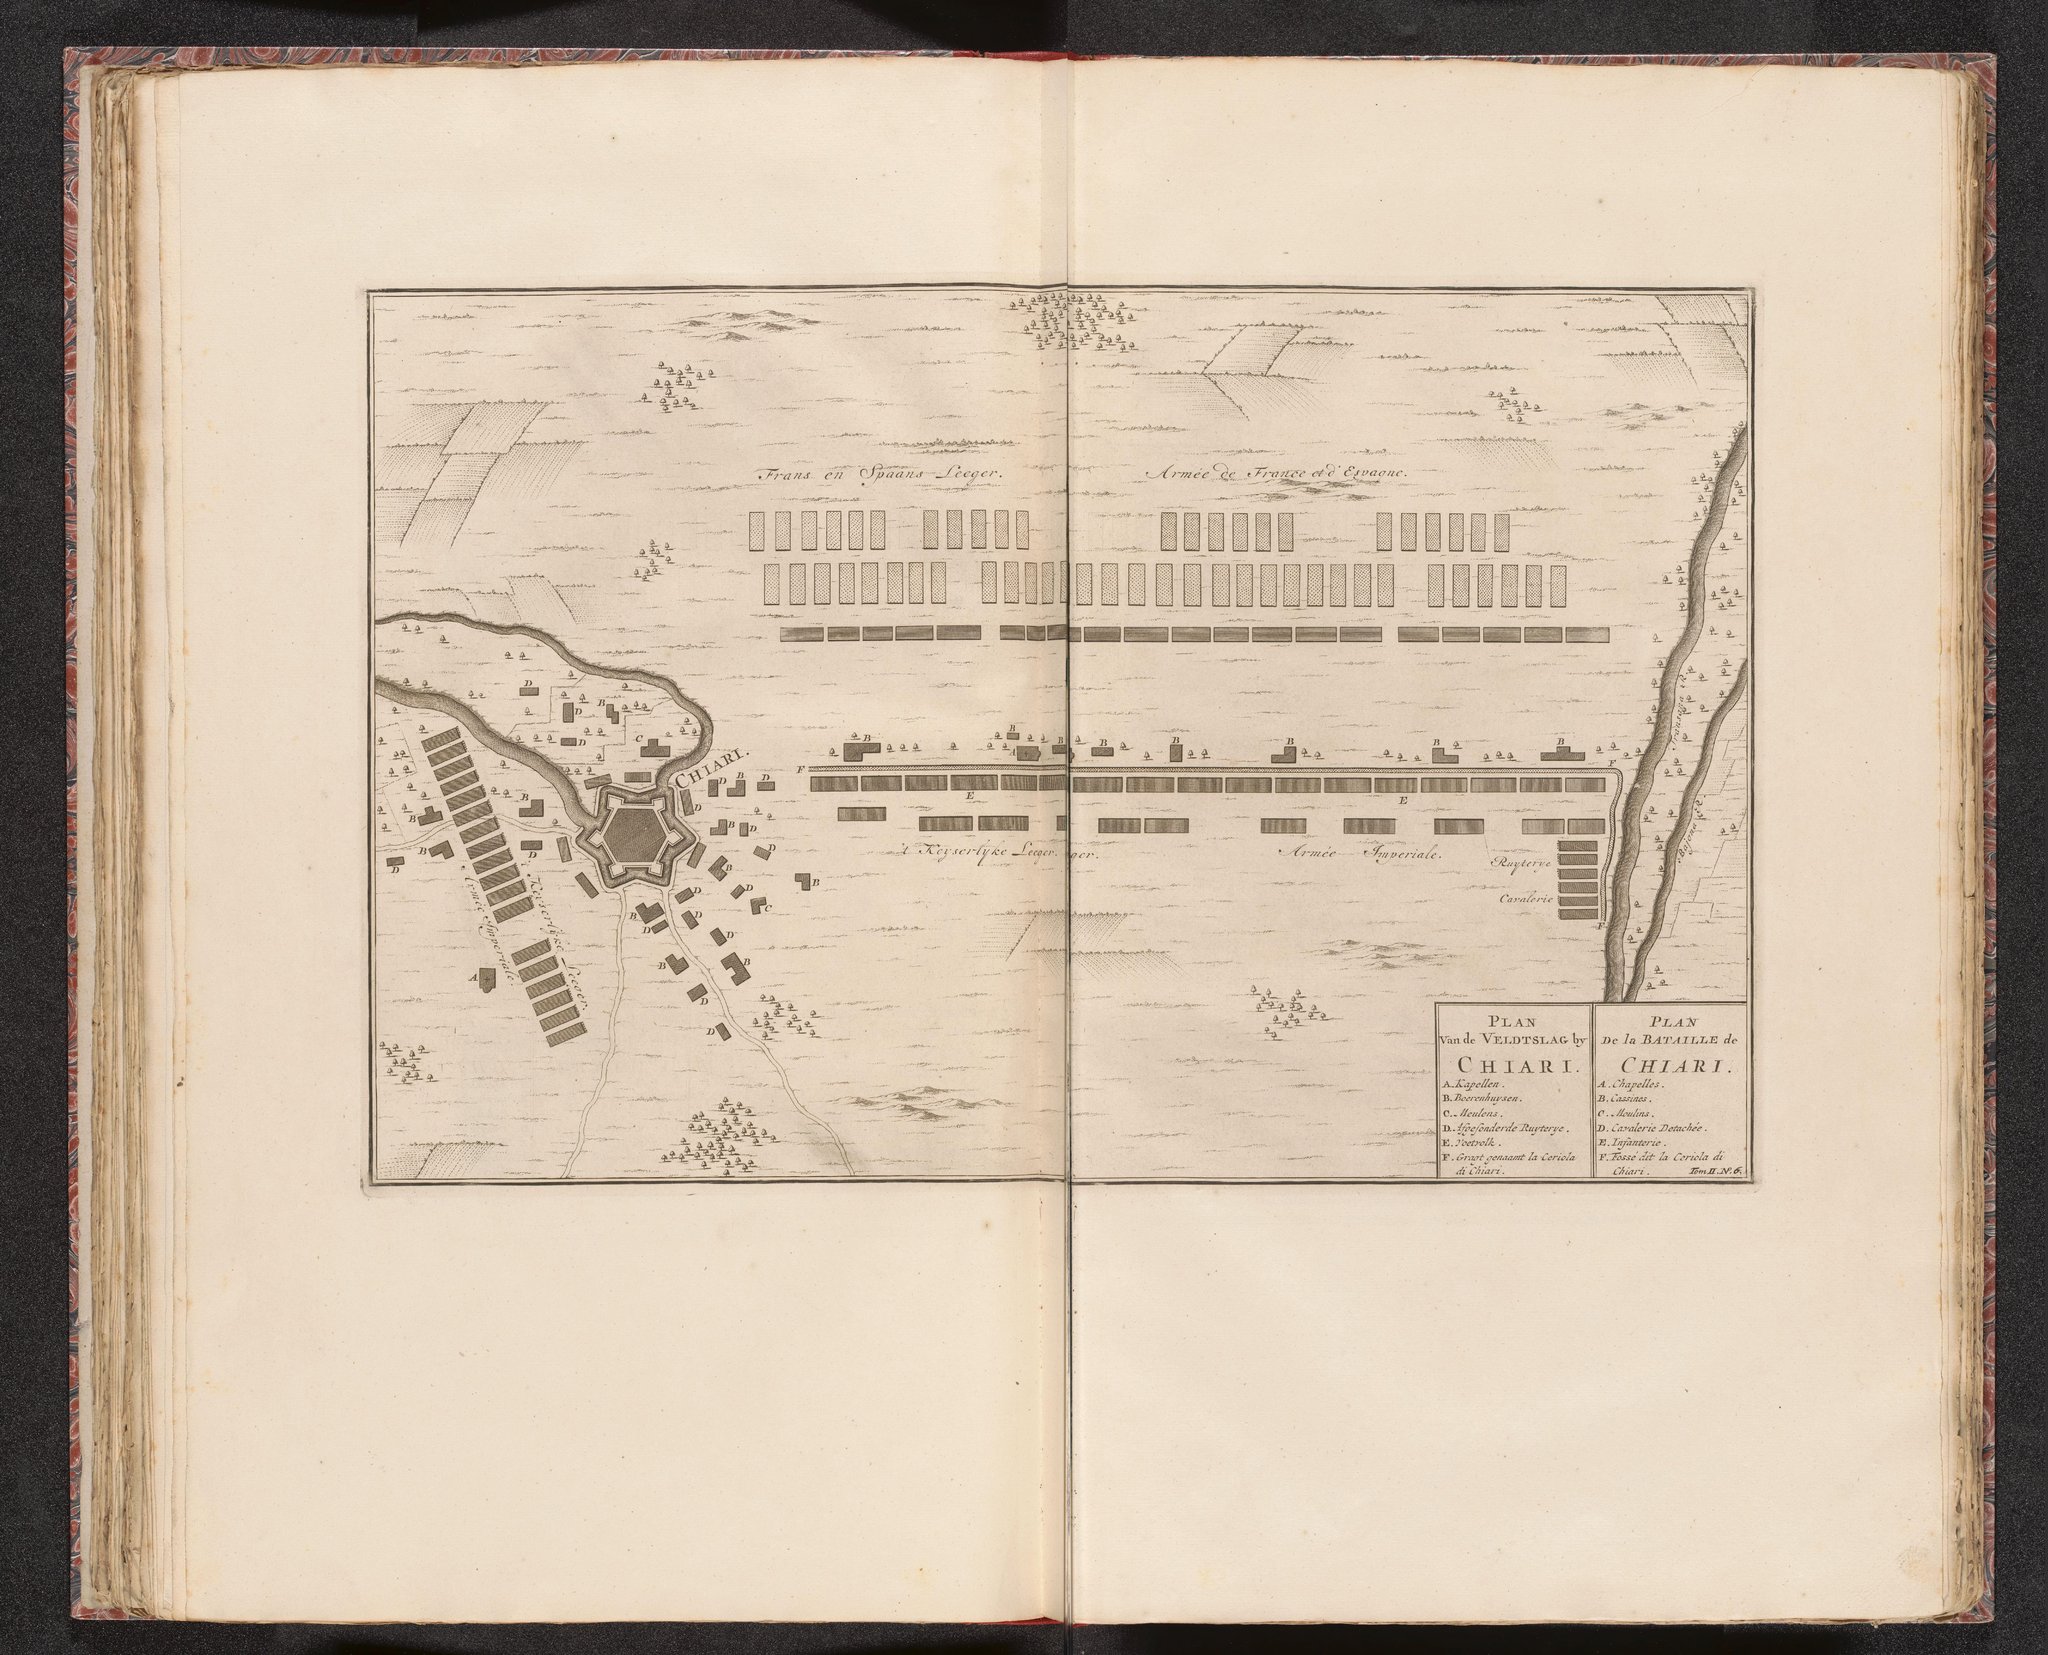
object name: print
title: Kaart van de veldslag bij Chiari, 1701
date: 1701-1713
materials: paper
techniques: etching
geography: the hague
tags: paris, vienna, eugenius van savoye, maps of separate countries or regions, battle (+ land forces)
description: Kaart van de veldslag bij Chieri (Chiari) tussen de Geallieerden en de Fransen en Spanjaarden, 1 september 1701. Genummerd rechtsonder: Tom. II. No. 6. Illustratie in het eerste deel van: Jean du Mont, Oorlogskundige beschryving van de veldslagen en belegeringen, der drie ... wydvermaarde krygsoversten... den Prins Eugenius van Savoye, den ... Hertog van Marlborough, en den Prins van Oranje en Nassau-Vriesland, in de editie van 1729. Dit eerste deel is gewijd aan de daden van Eugenius, prins van Savoye.